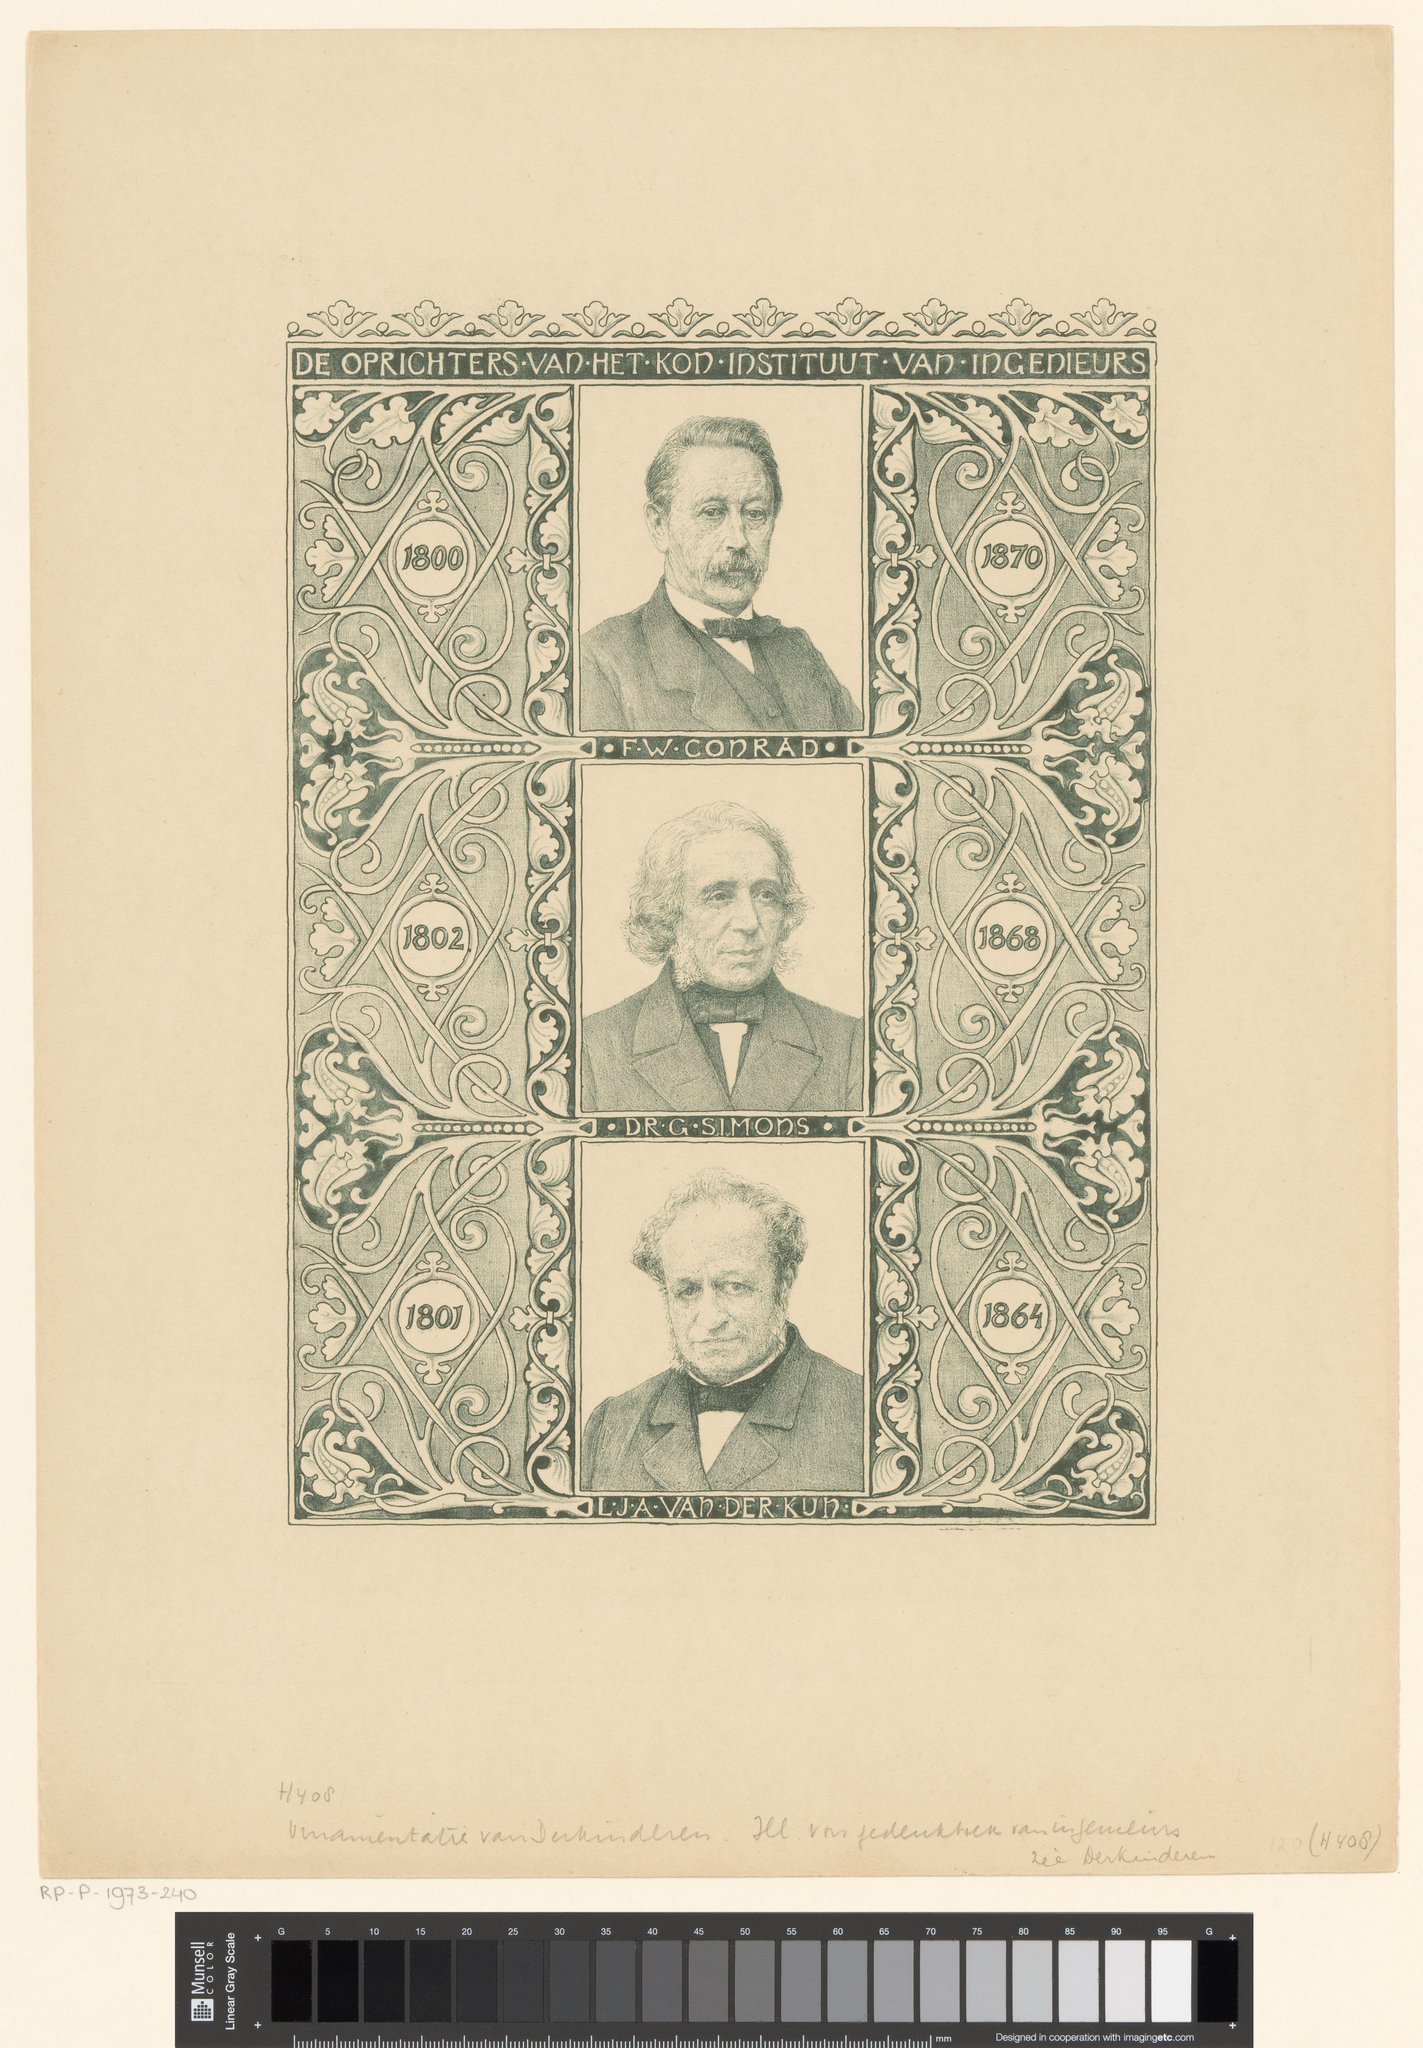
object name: book illustration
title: De oprichters van het Kon Instituut van ingenieurs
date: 1897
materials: paper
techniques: lithograph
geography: netherlands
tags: frederik willem conrad (ii), the hague, utrecht, engineer, historical persons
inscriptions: collector's mark: Lugt 2228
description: Prent uit: S.n. Gedenkboek uitgegeven ter gelegenheid van het vijftigjarig bestaan van het Koninklijk Instituut van Ingenieurs 1847-1897. Den Haag: Van Langenhuysen, Gebroeders J. en H. van, 1897.